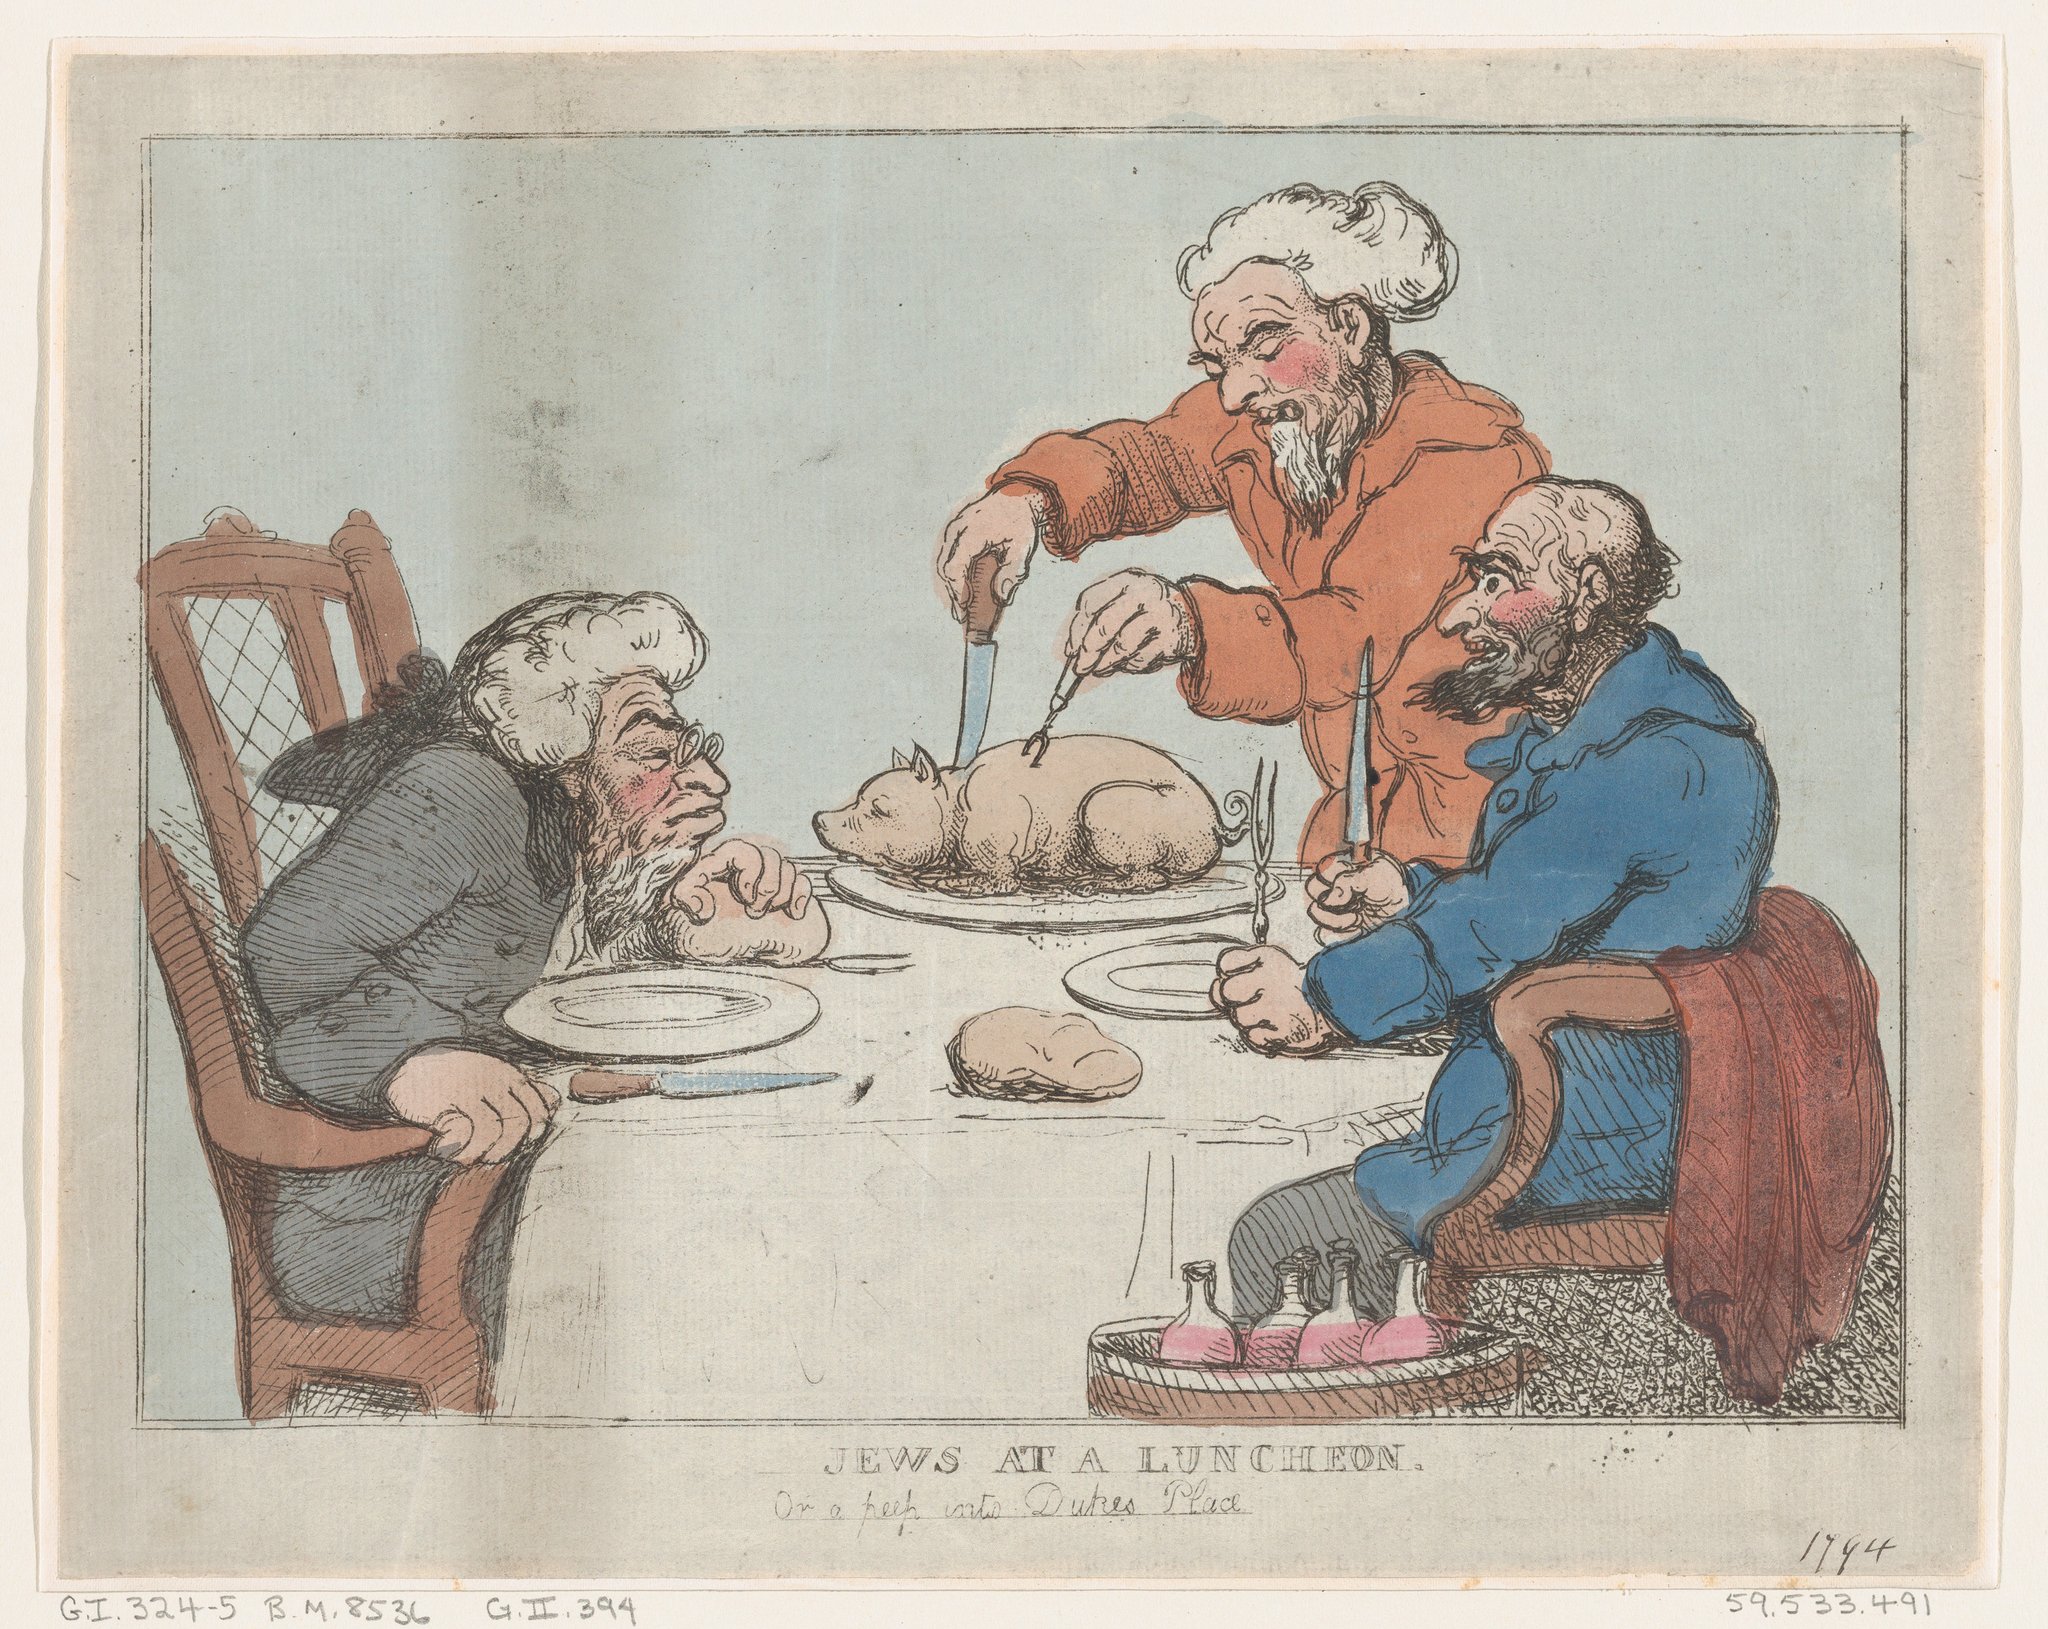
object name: print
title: Jews at a Luncheon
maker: thomas rowlandson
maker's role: artist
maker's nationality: british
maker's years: 1757-1827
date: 1794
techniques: etching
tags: men,pigs,dining